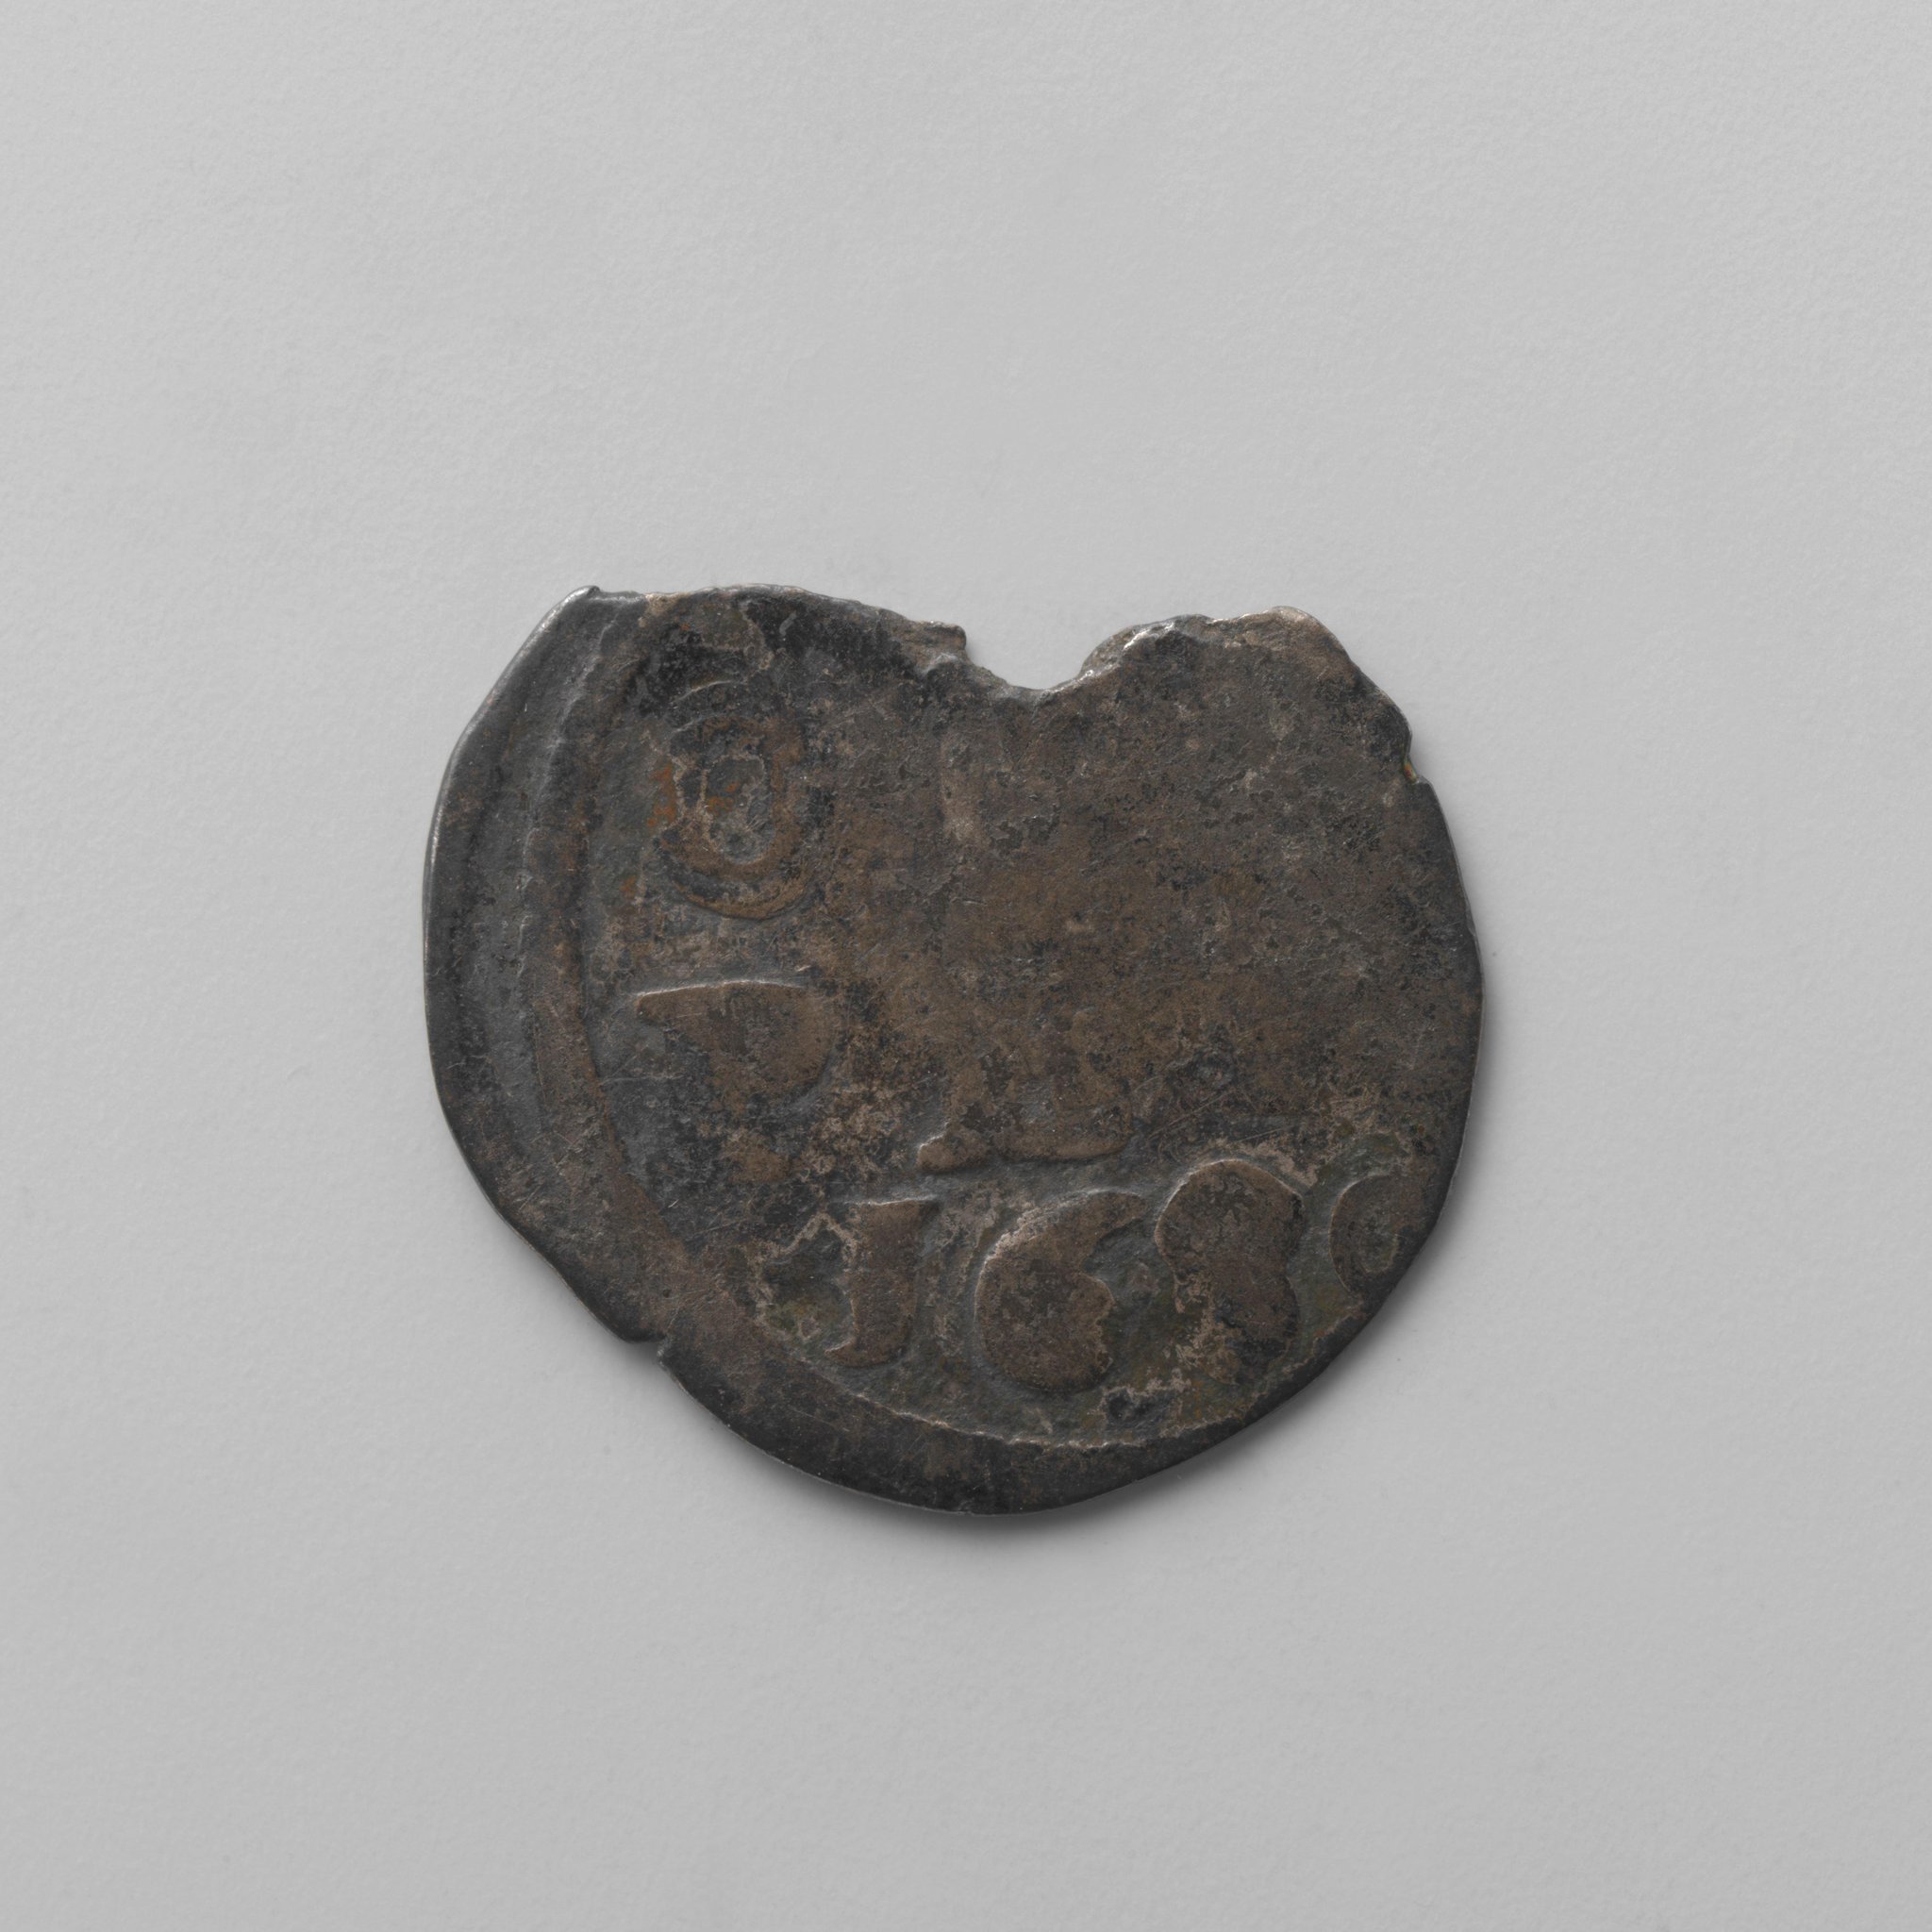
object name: coin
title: Kampen, dubbele stuiver, 1680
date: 1680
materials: silver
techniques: striking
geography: kampen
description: Zilveren munt. Voorzijde: tussen waarde-aanduiding 2 S generaliteitsleeuw. Keerzijde: tweeregelig opschrift, waaronder jaartal.